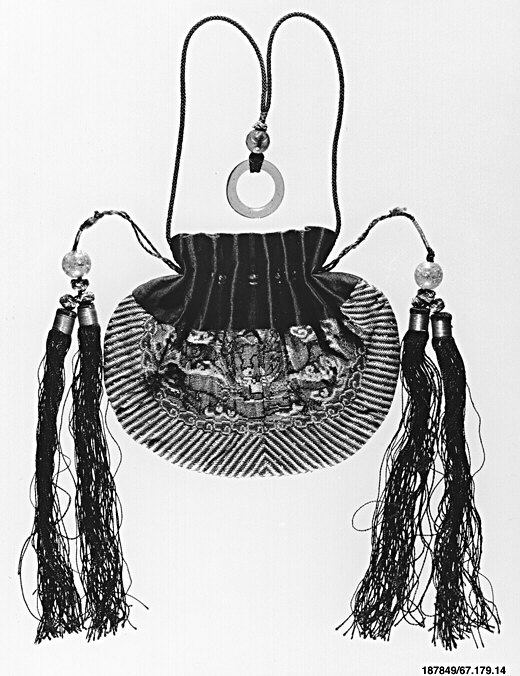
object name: purse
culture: chinese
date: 1801-1900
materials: metal thread, silk